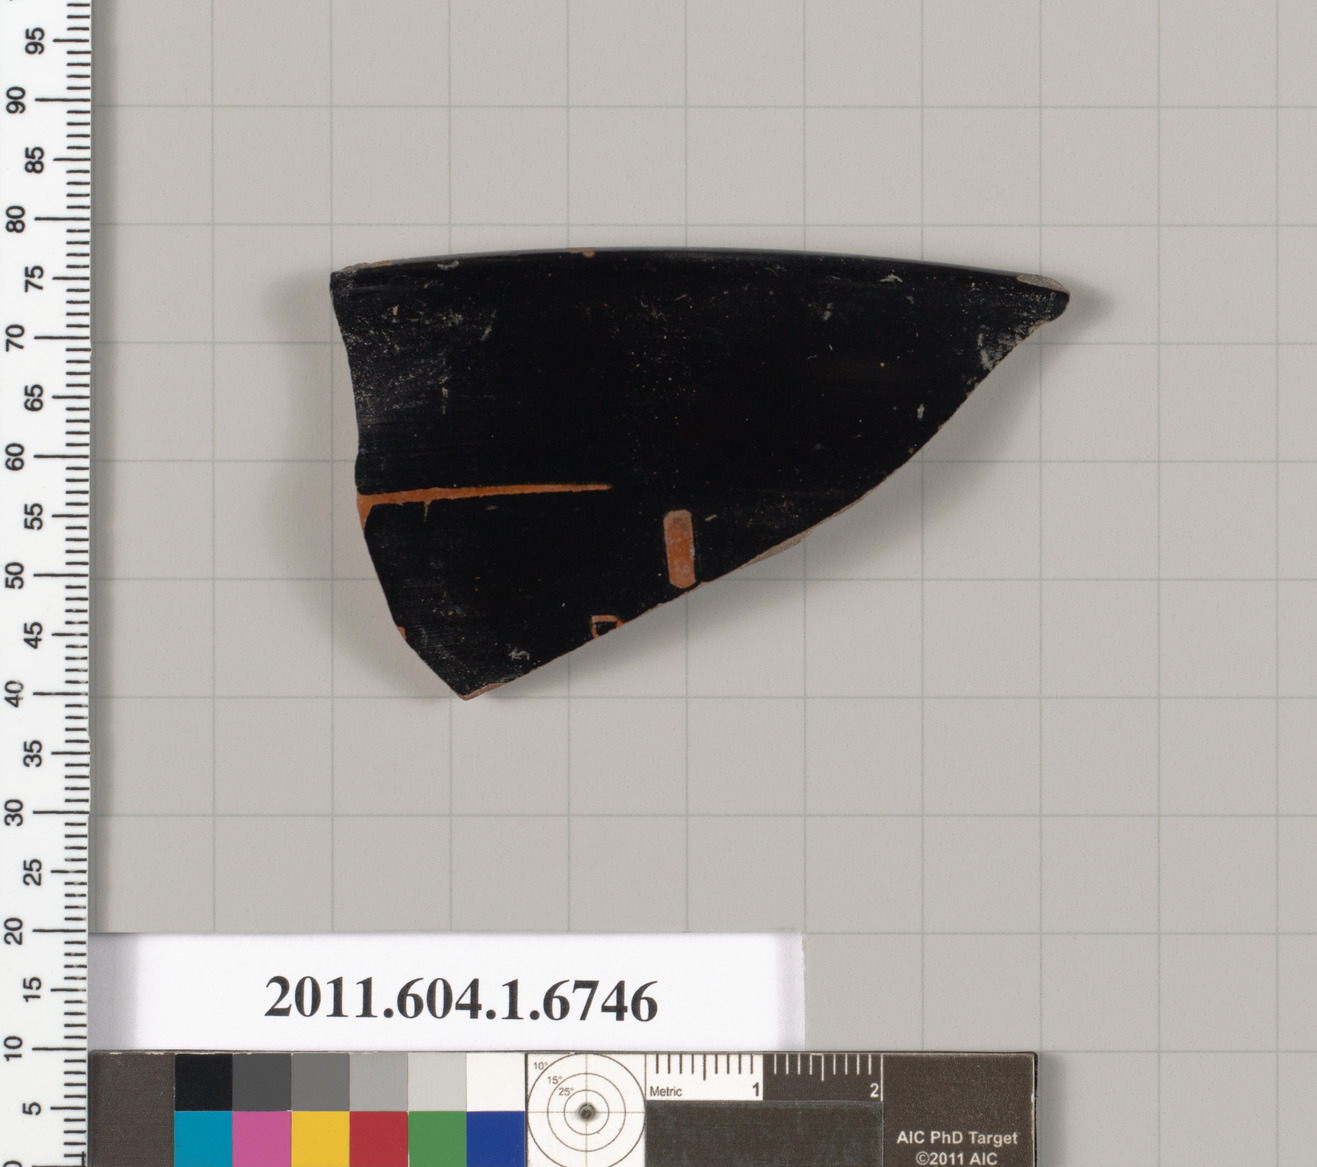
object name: kylix fragment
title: Terracotta rim fragment of a kylix (drinking cup)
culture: greek, attic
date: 490-470 BCE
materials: terracotta